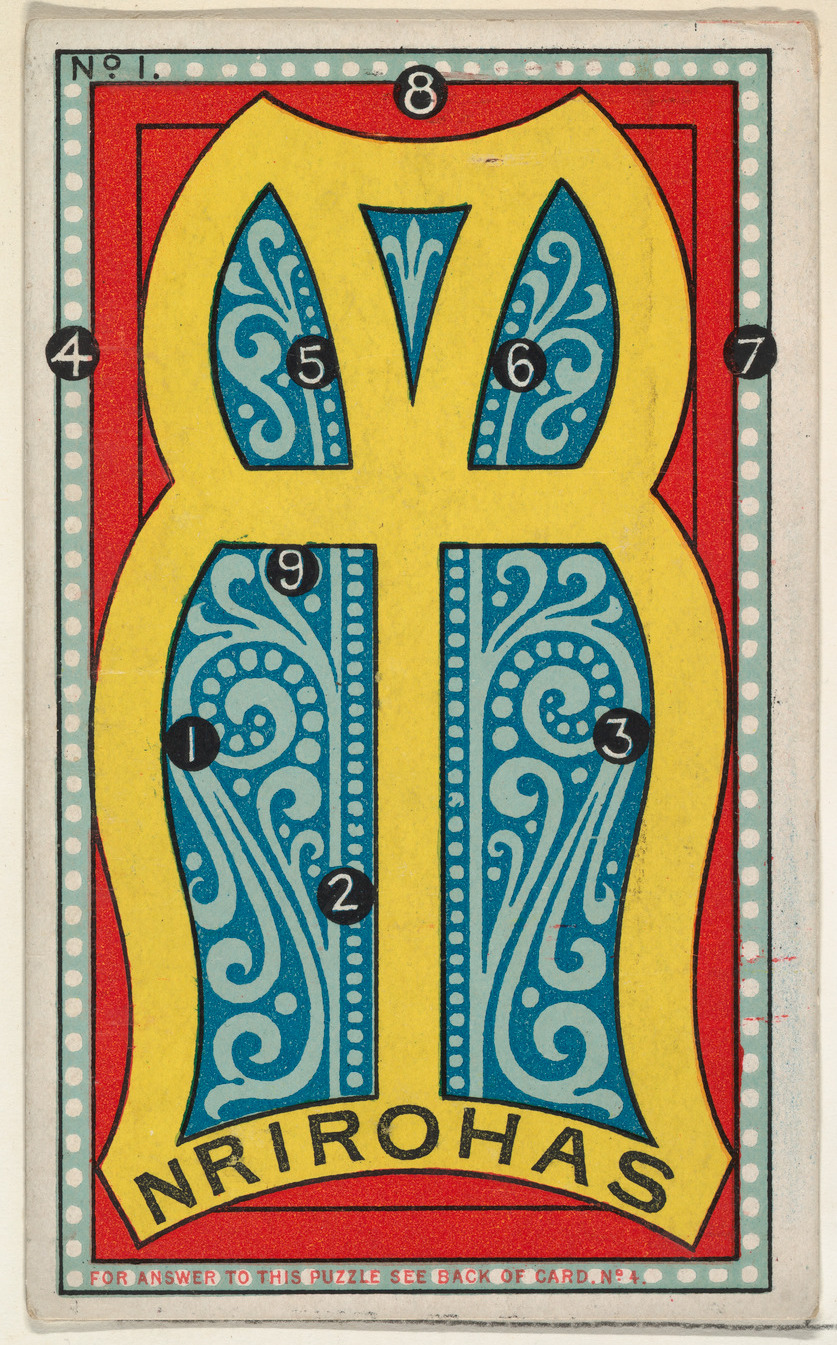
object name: print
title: Puzzle Card Number 1, from the Jokes series (N118) issued by Duke Sons & Co. to promote Honest Long Cut Tobacco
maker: w. duke, sons & co.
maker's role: publisher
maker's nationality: american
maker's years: 1870-1920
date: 1890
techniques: color lithograph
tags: games